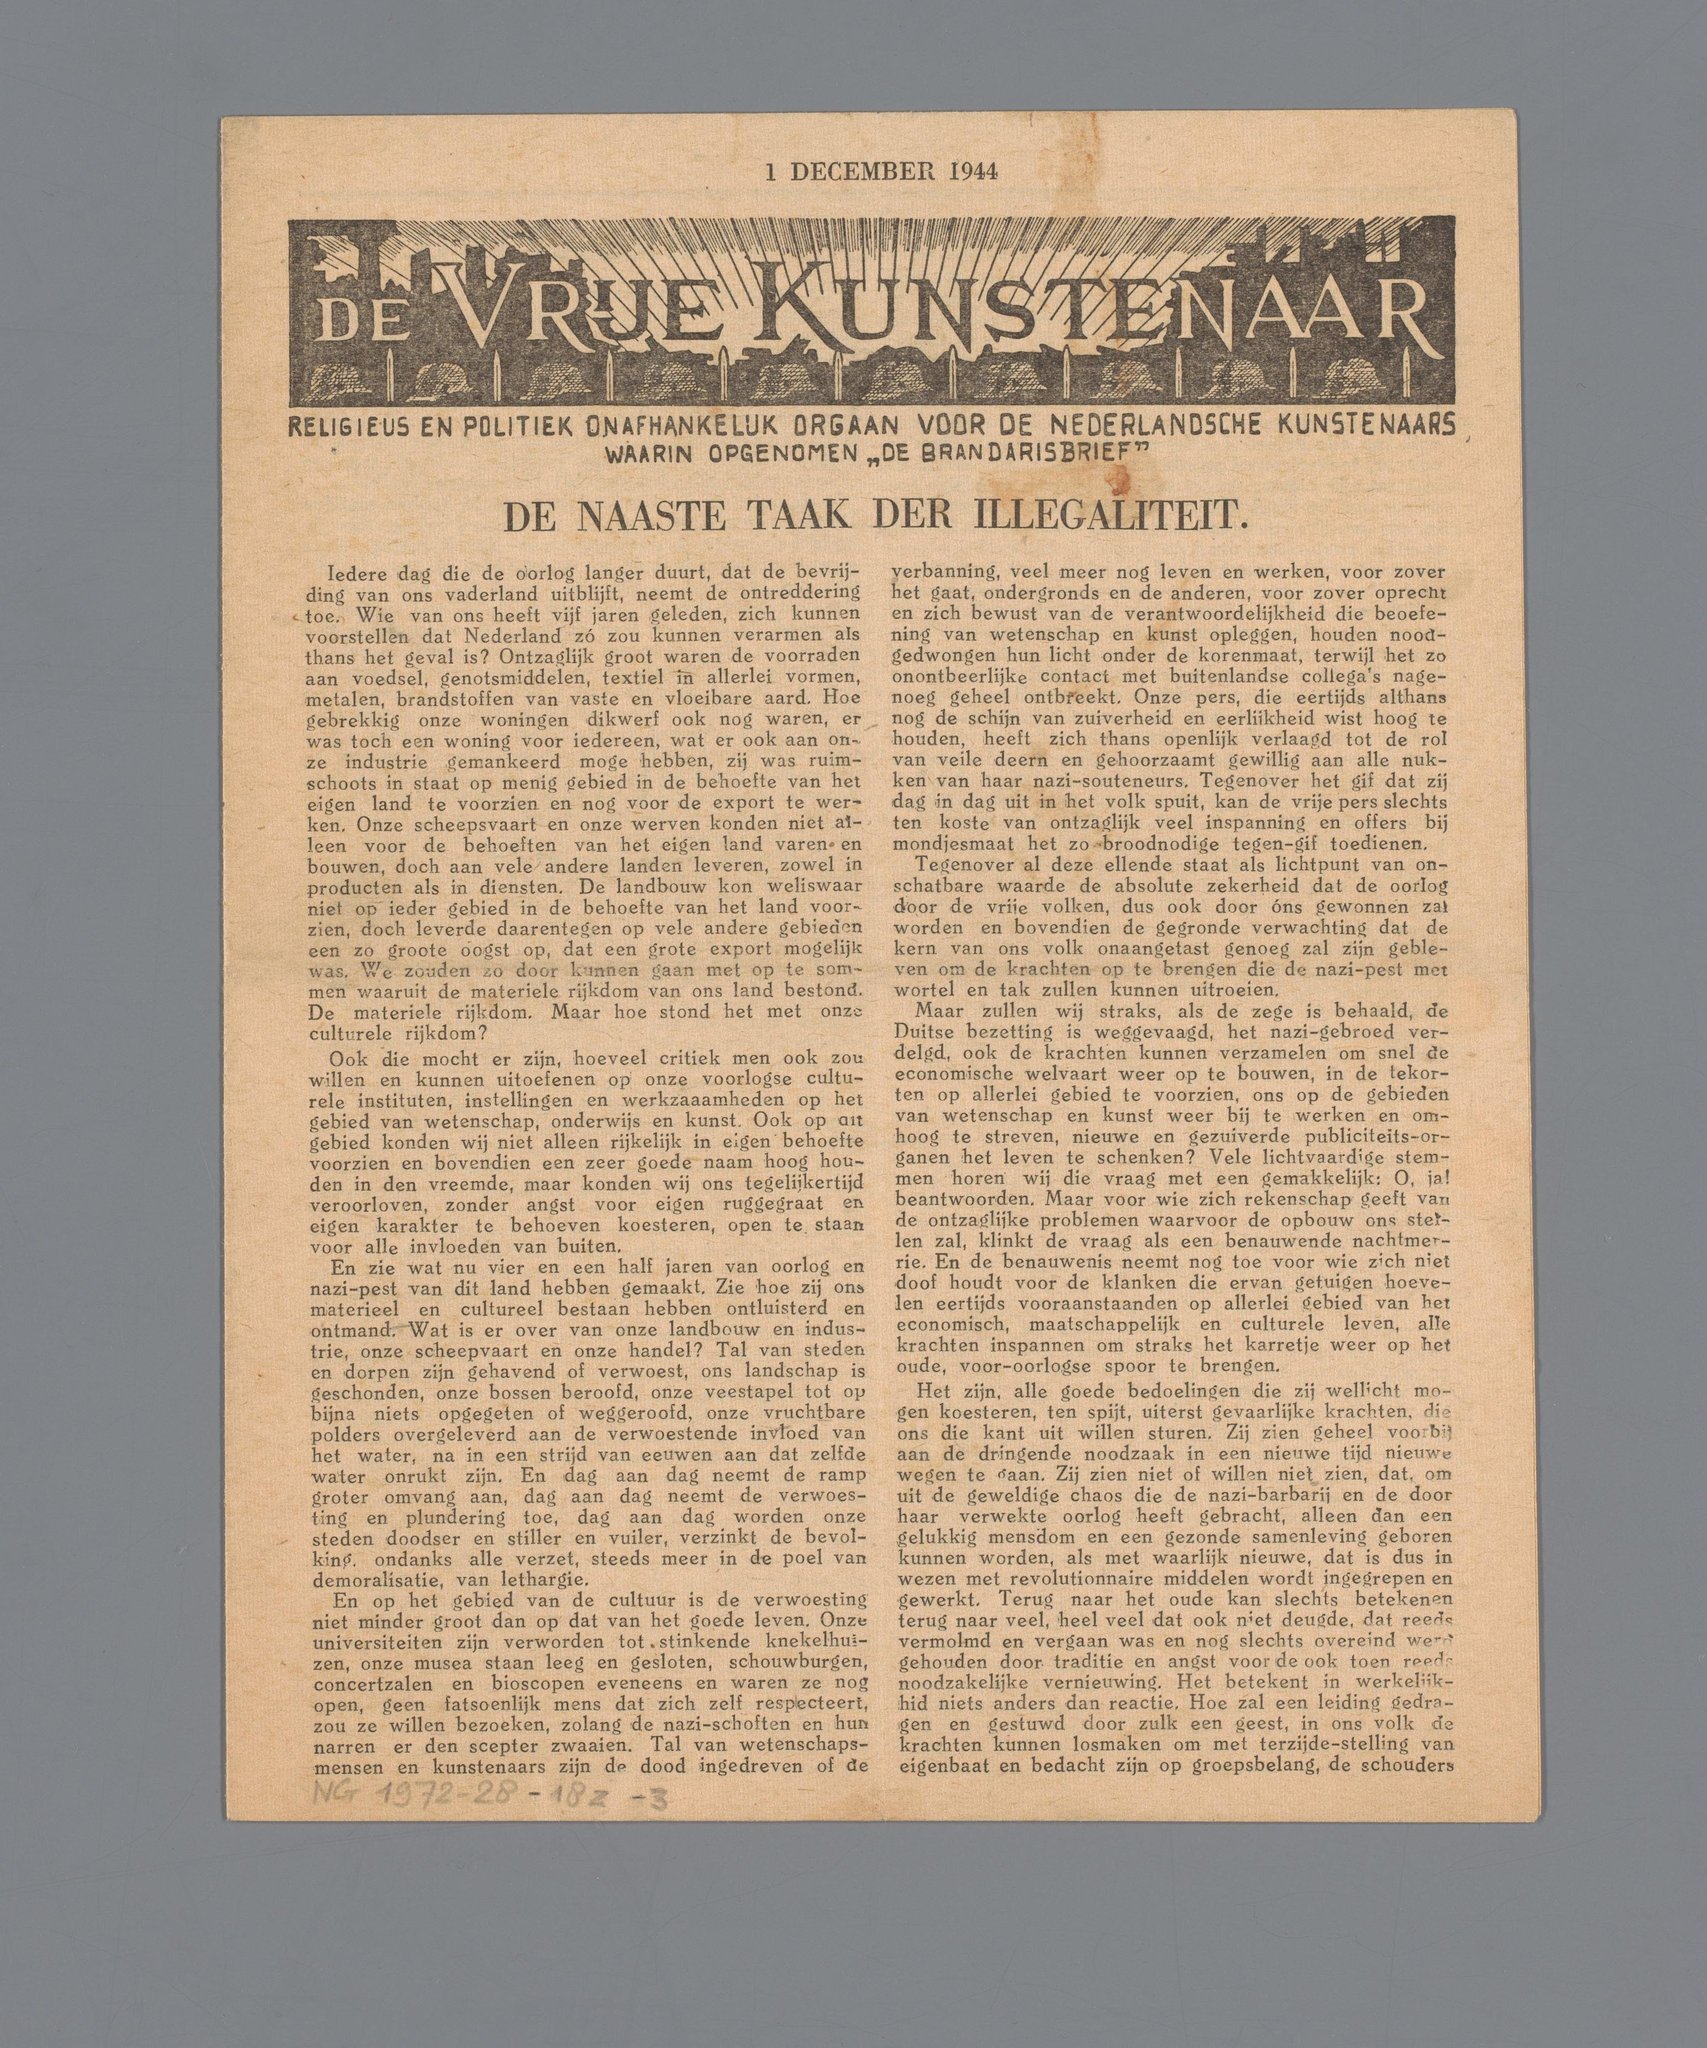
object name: magazine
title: De Vrije Kunstenaar; religieus en politiek onafhankelijk orgaan voor de Nederlandsche Kunstenaars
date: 1944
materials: paper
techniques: printing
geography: amsterdam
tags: netherlands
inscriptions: date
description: Nummer van 'De Vrije Kunstenaar', 8 genummerde pp. Opschrift: 'De naaste taak der illegaliteit'. Gedateerd: 1 december 1944.